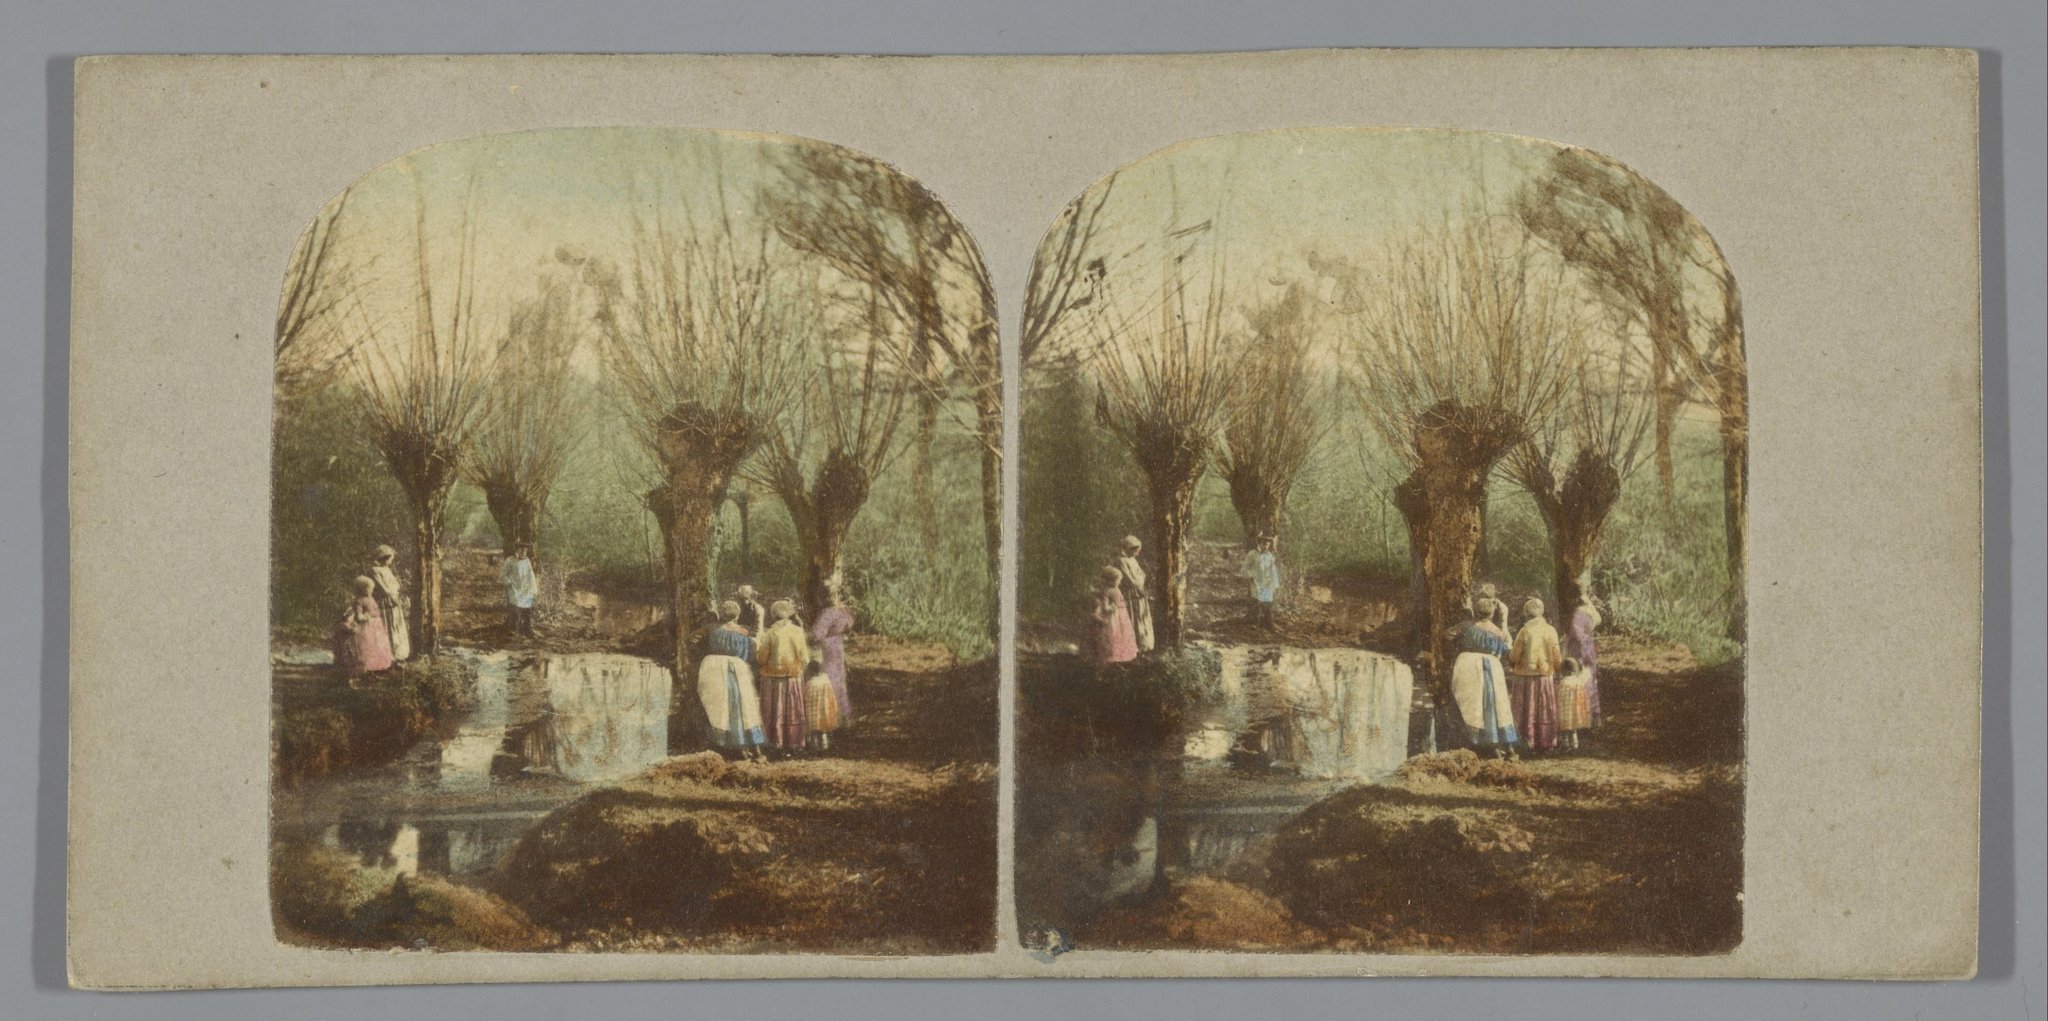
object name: stereograph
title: Mensen in een bos bij water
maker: Anonymous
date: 1852-1863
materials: cardboard, paper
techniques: albumen print, hand coloring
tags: forest, wood, fen, du. 'ven'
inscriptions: number: ‘150’